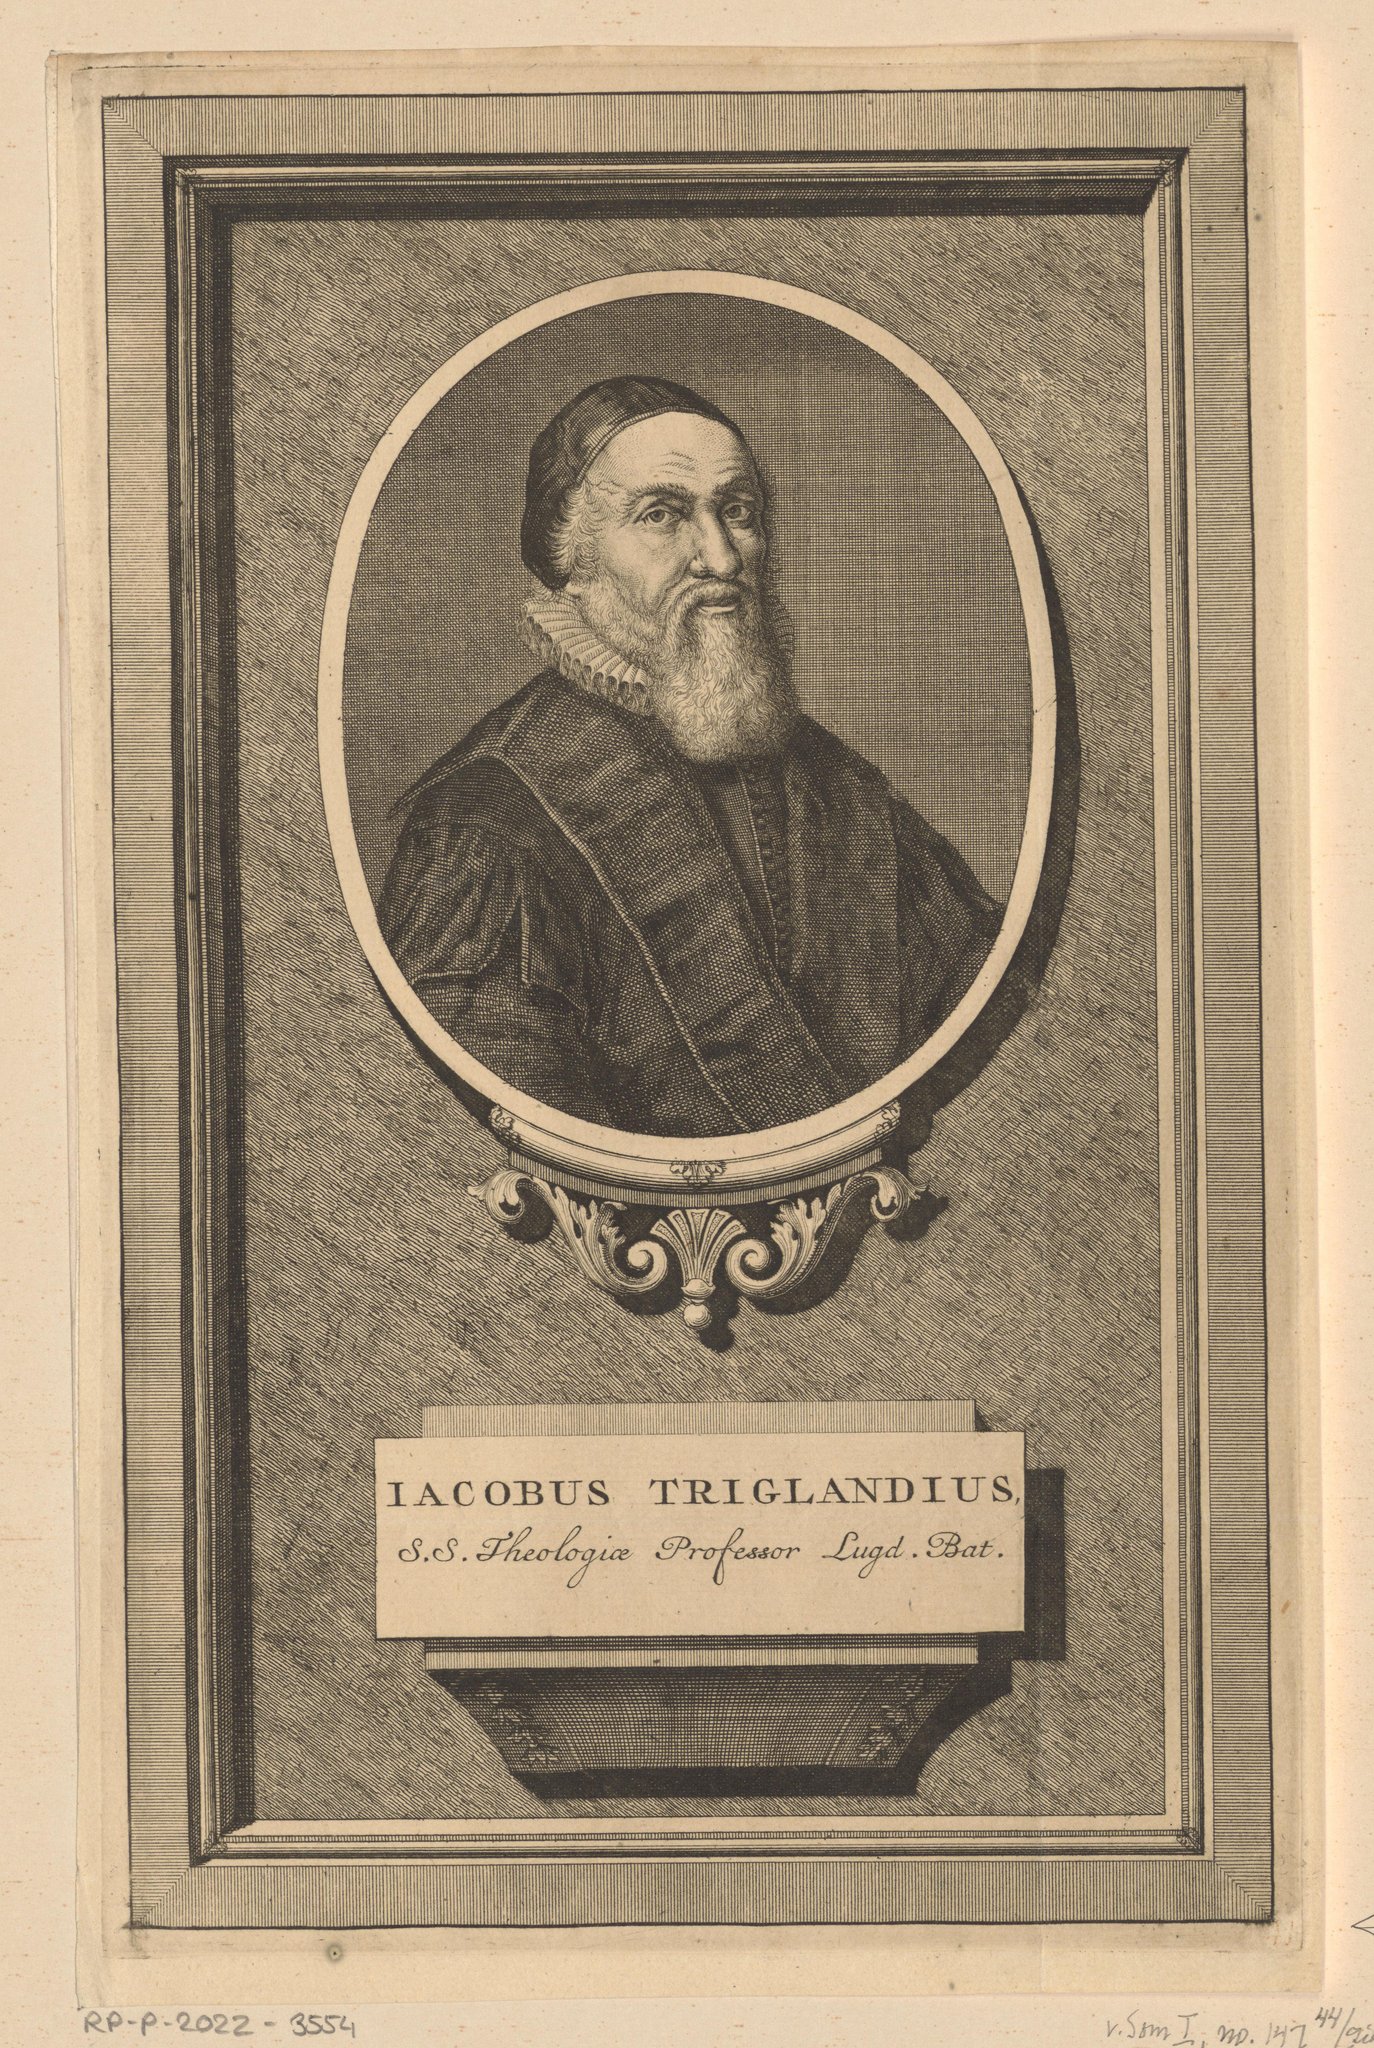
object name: print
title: Beroemde mannen aan de universiteit van Leiden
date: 1716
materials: paper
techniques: engraving, etching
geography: leiden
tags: jacobus trigland (i), theologian, historical persons, portrait of a writer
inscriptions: number: ‘44’, inscription: ‘KB’